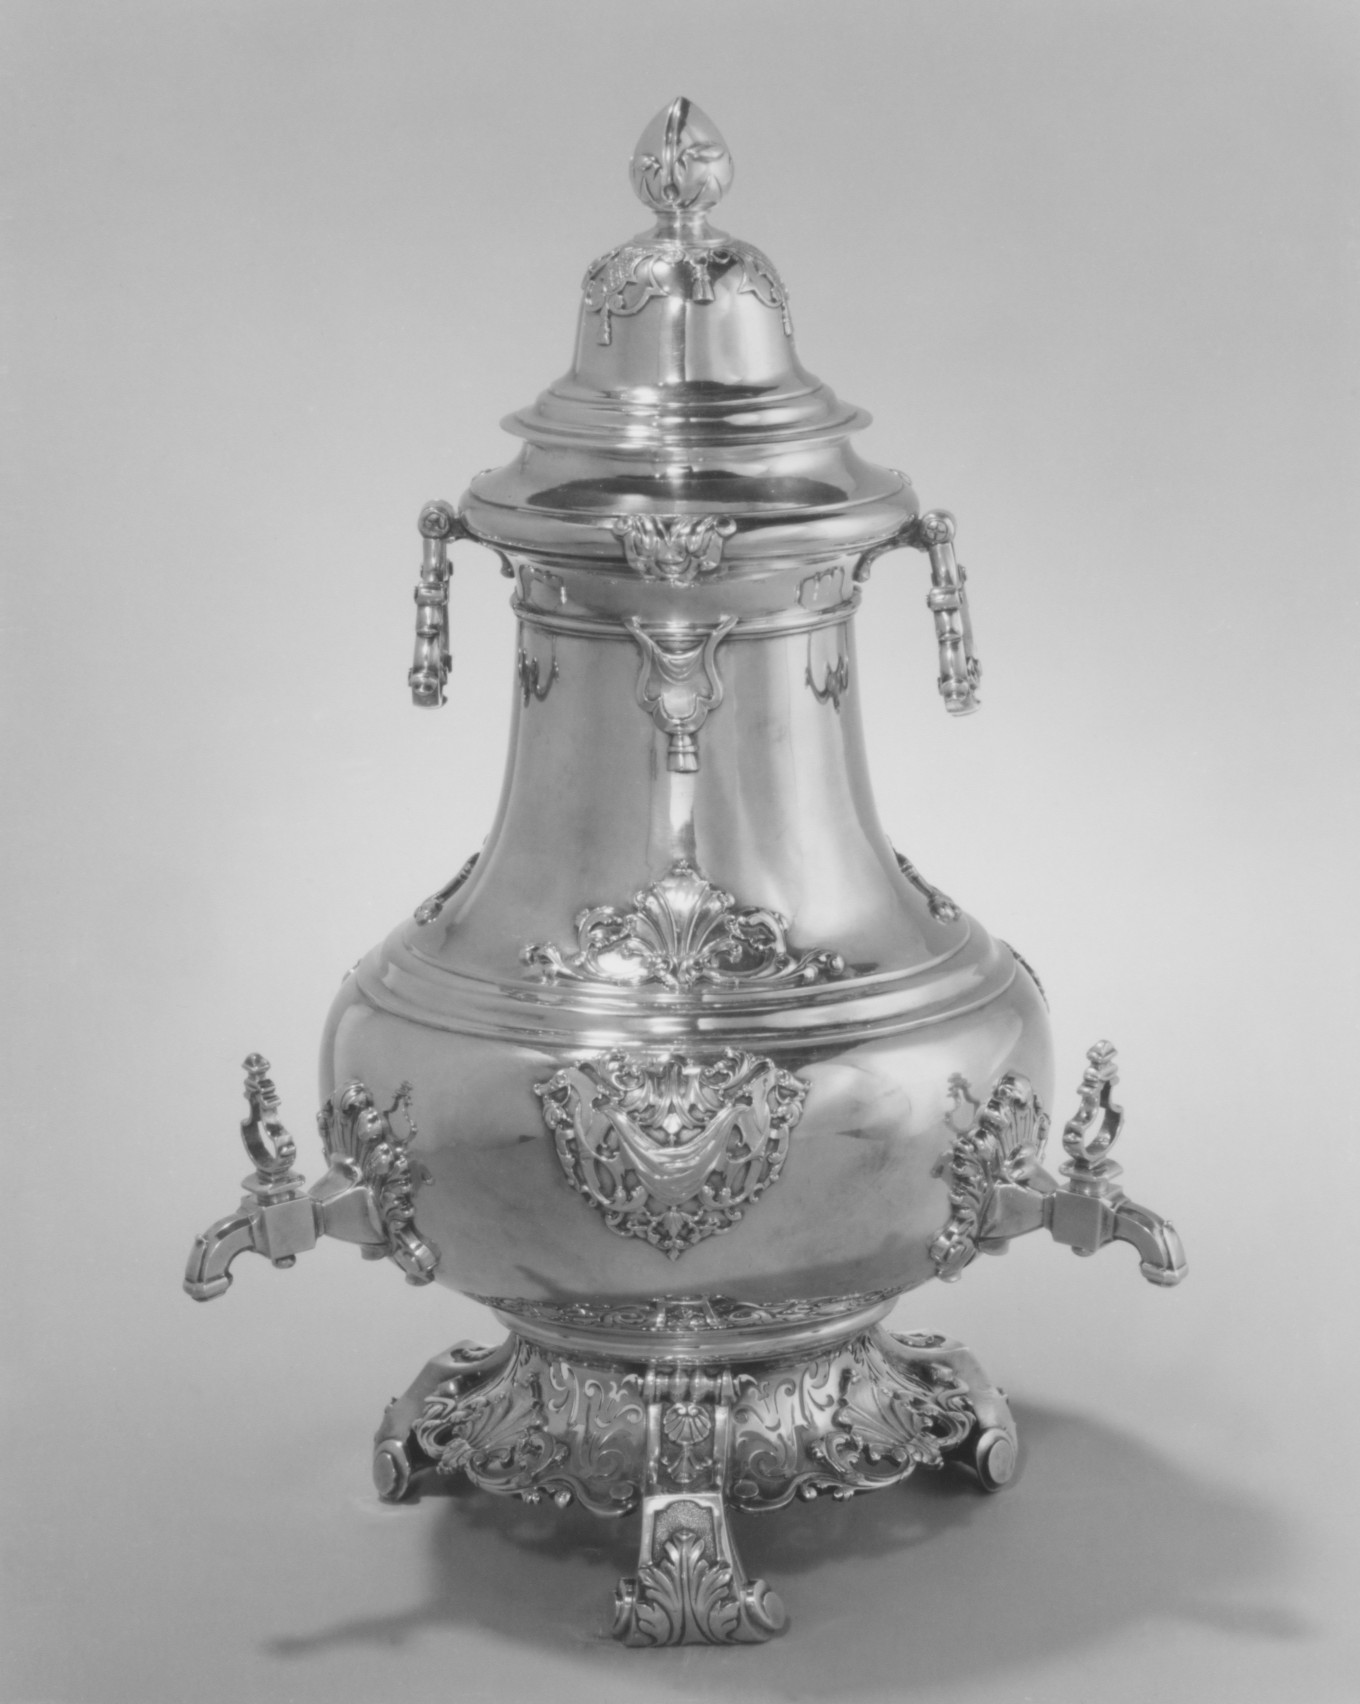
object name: coffee urn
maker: tijmon suyk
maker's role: maker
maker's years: 1699-1754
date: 1733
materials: silver